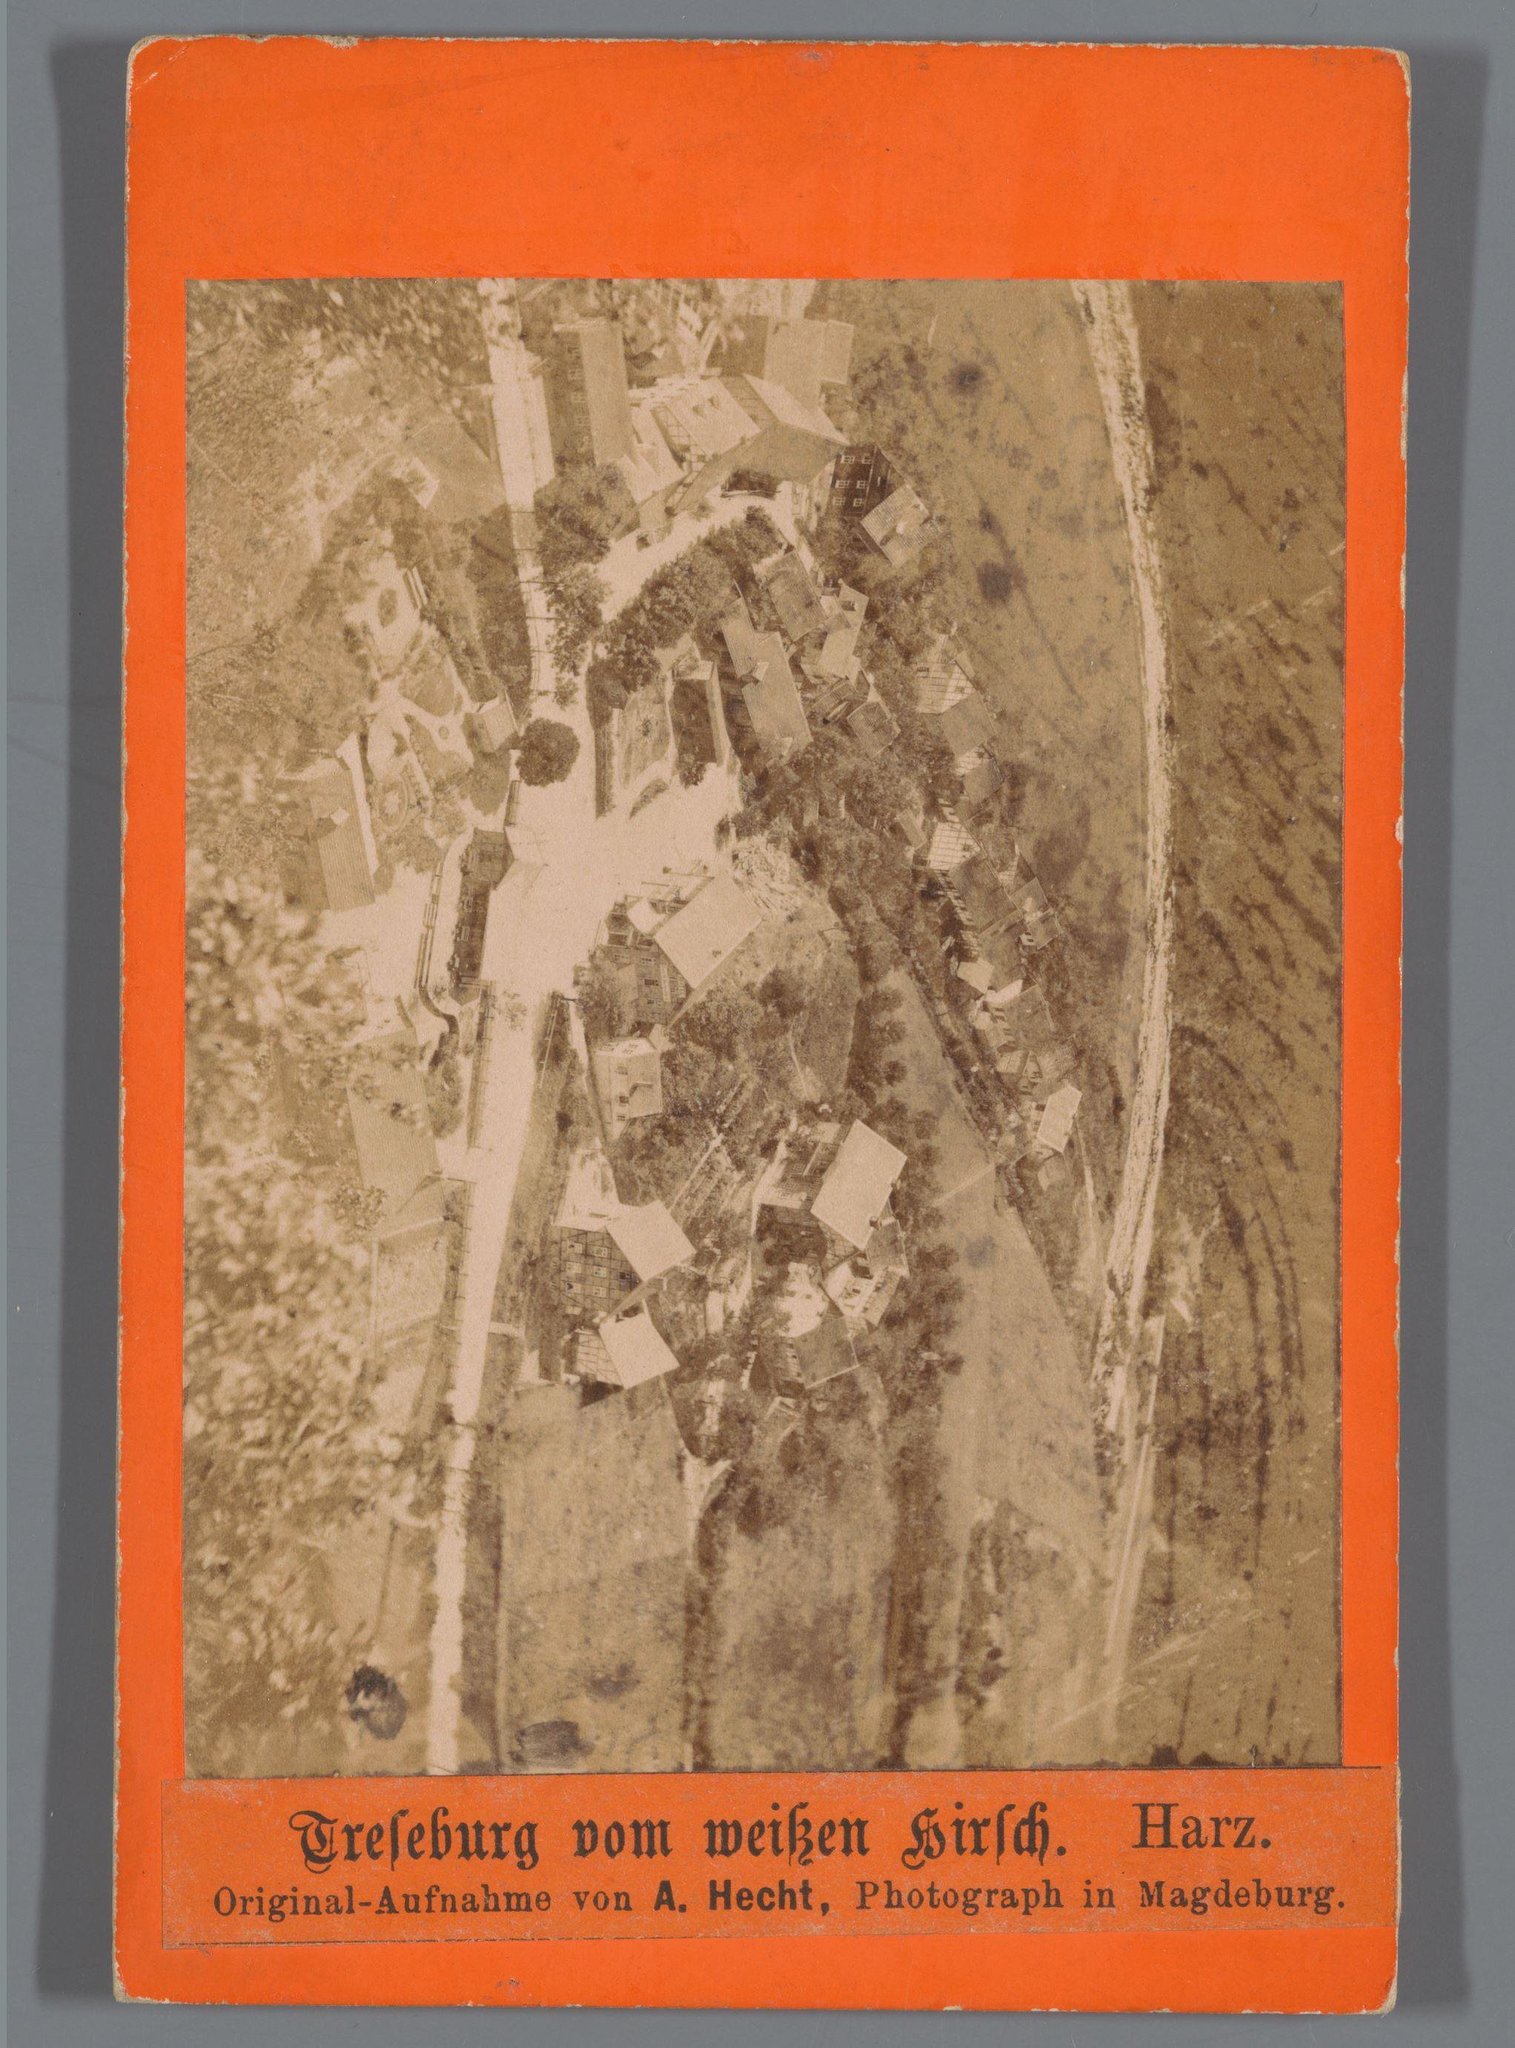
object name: carte de visite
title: Harz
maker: adolph hecht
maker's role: fotograaf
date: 1855-1885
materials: cardboard, paper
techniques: albumen print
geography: treseburg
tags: village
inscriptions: number: ‘59’, inscription: ‘Original-Aufnahme von A. Hecht, Photograph in Magdeburg.’